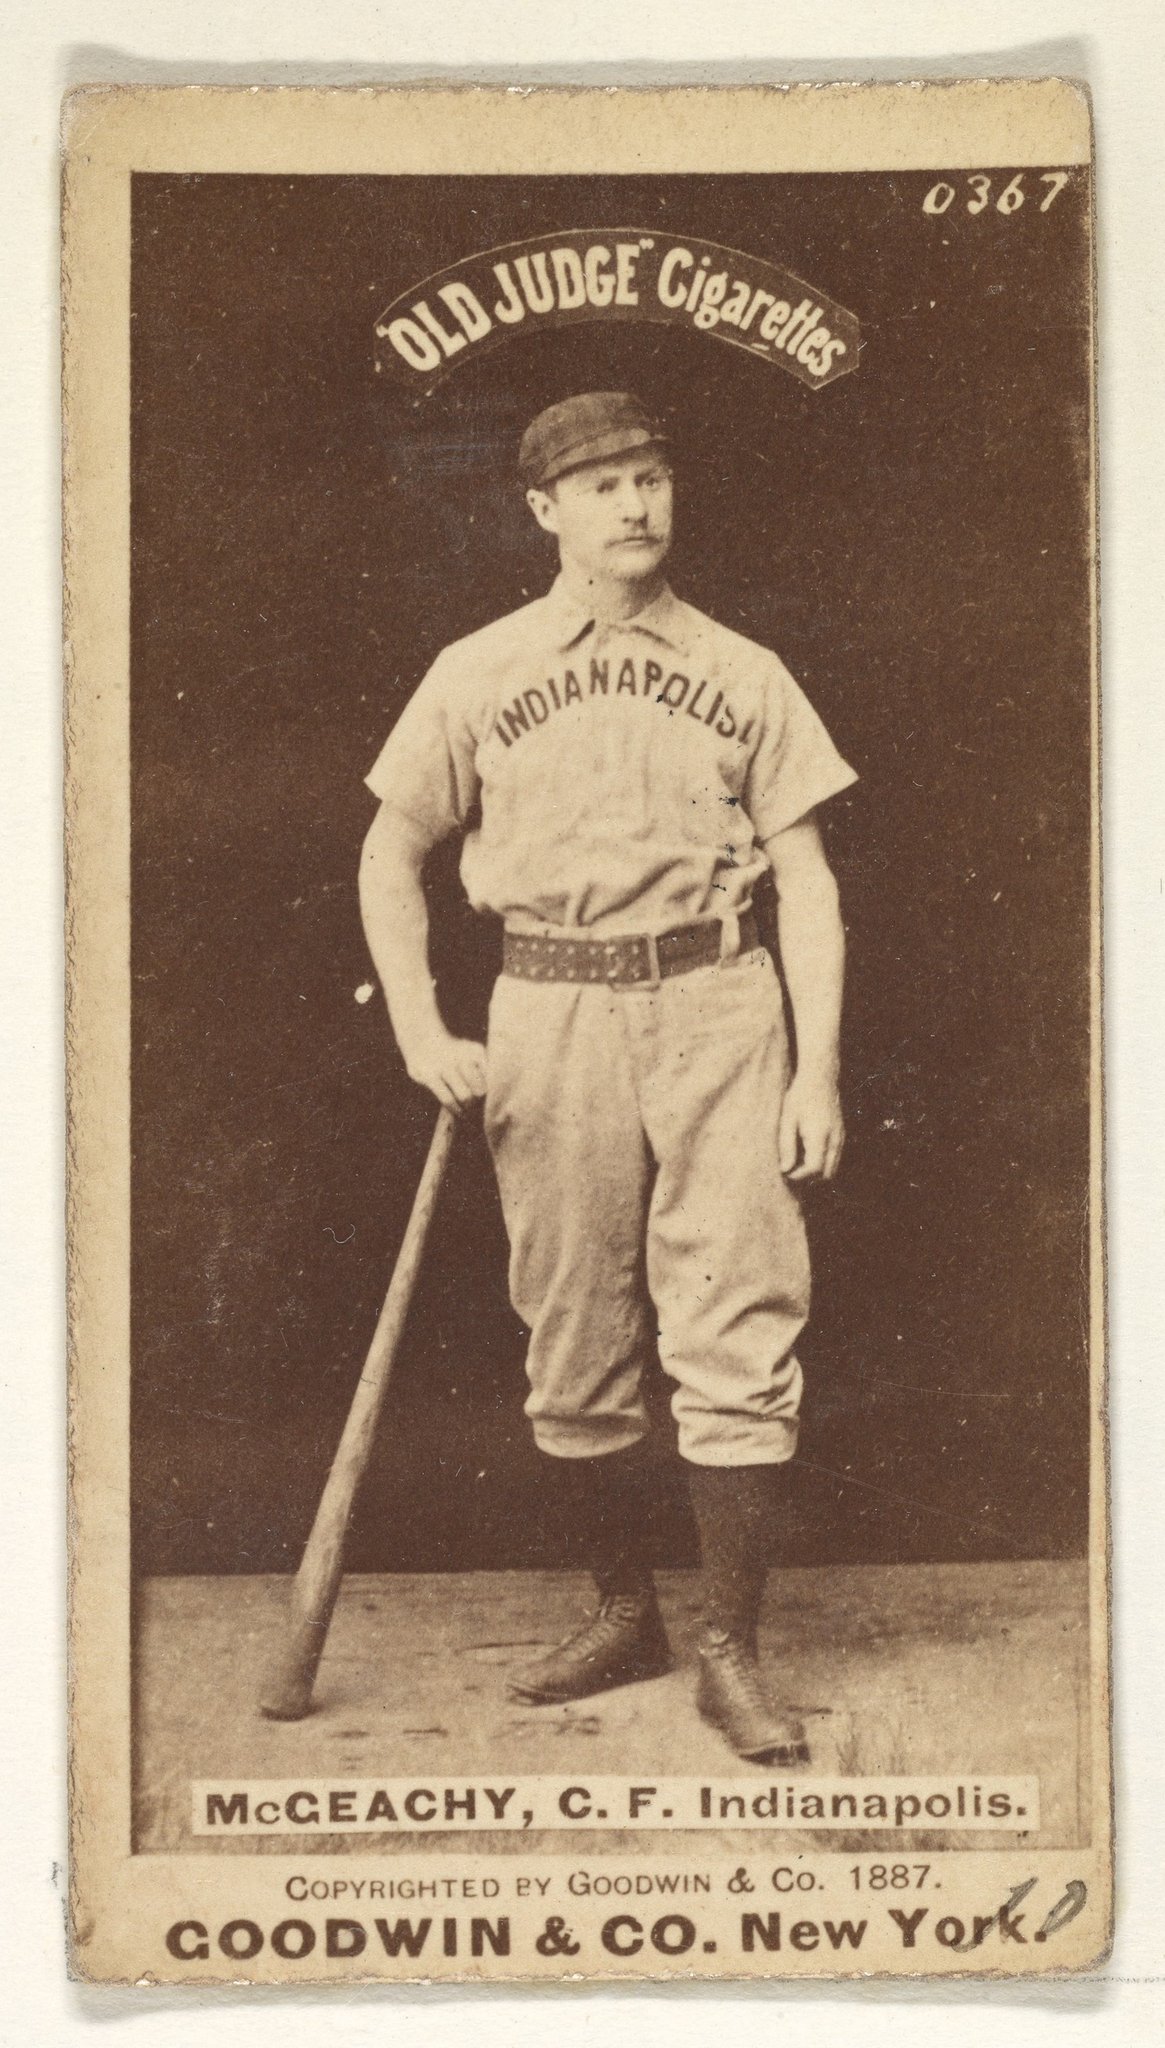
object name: baseball card, photograph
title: Jack McGeachey, Center Field, Indianapolis, from the Old Judge series (N172) for Old Judge Cigarettes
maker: goodwin & company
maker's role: publisher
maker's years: 1850-1950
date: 1887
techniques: albumen silver print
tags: men,portraits,baseball,athletes